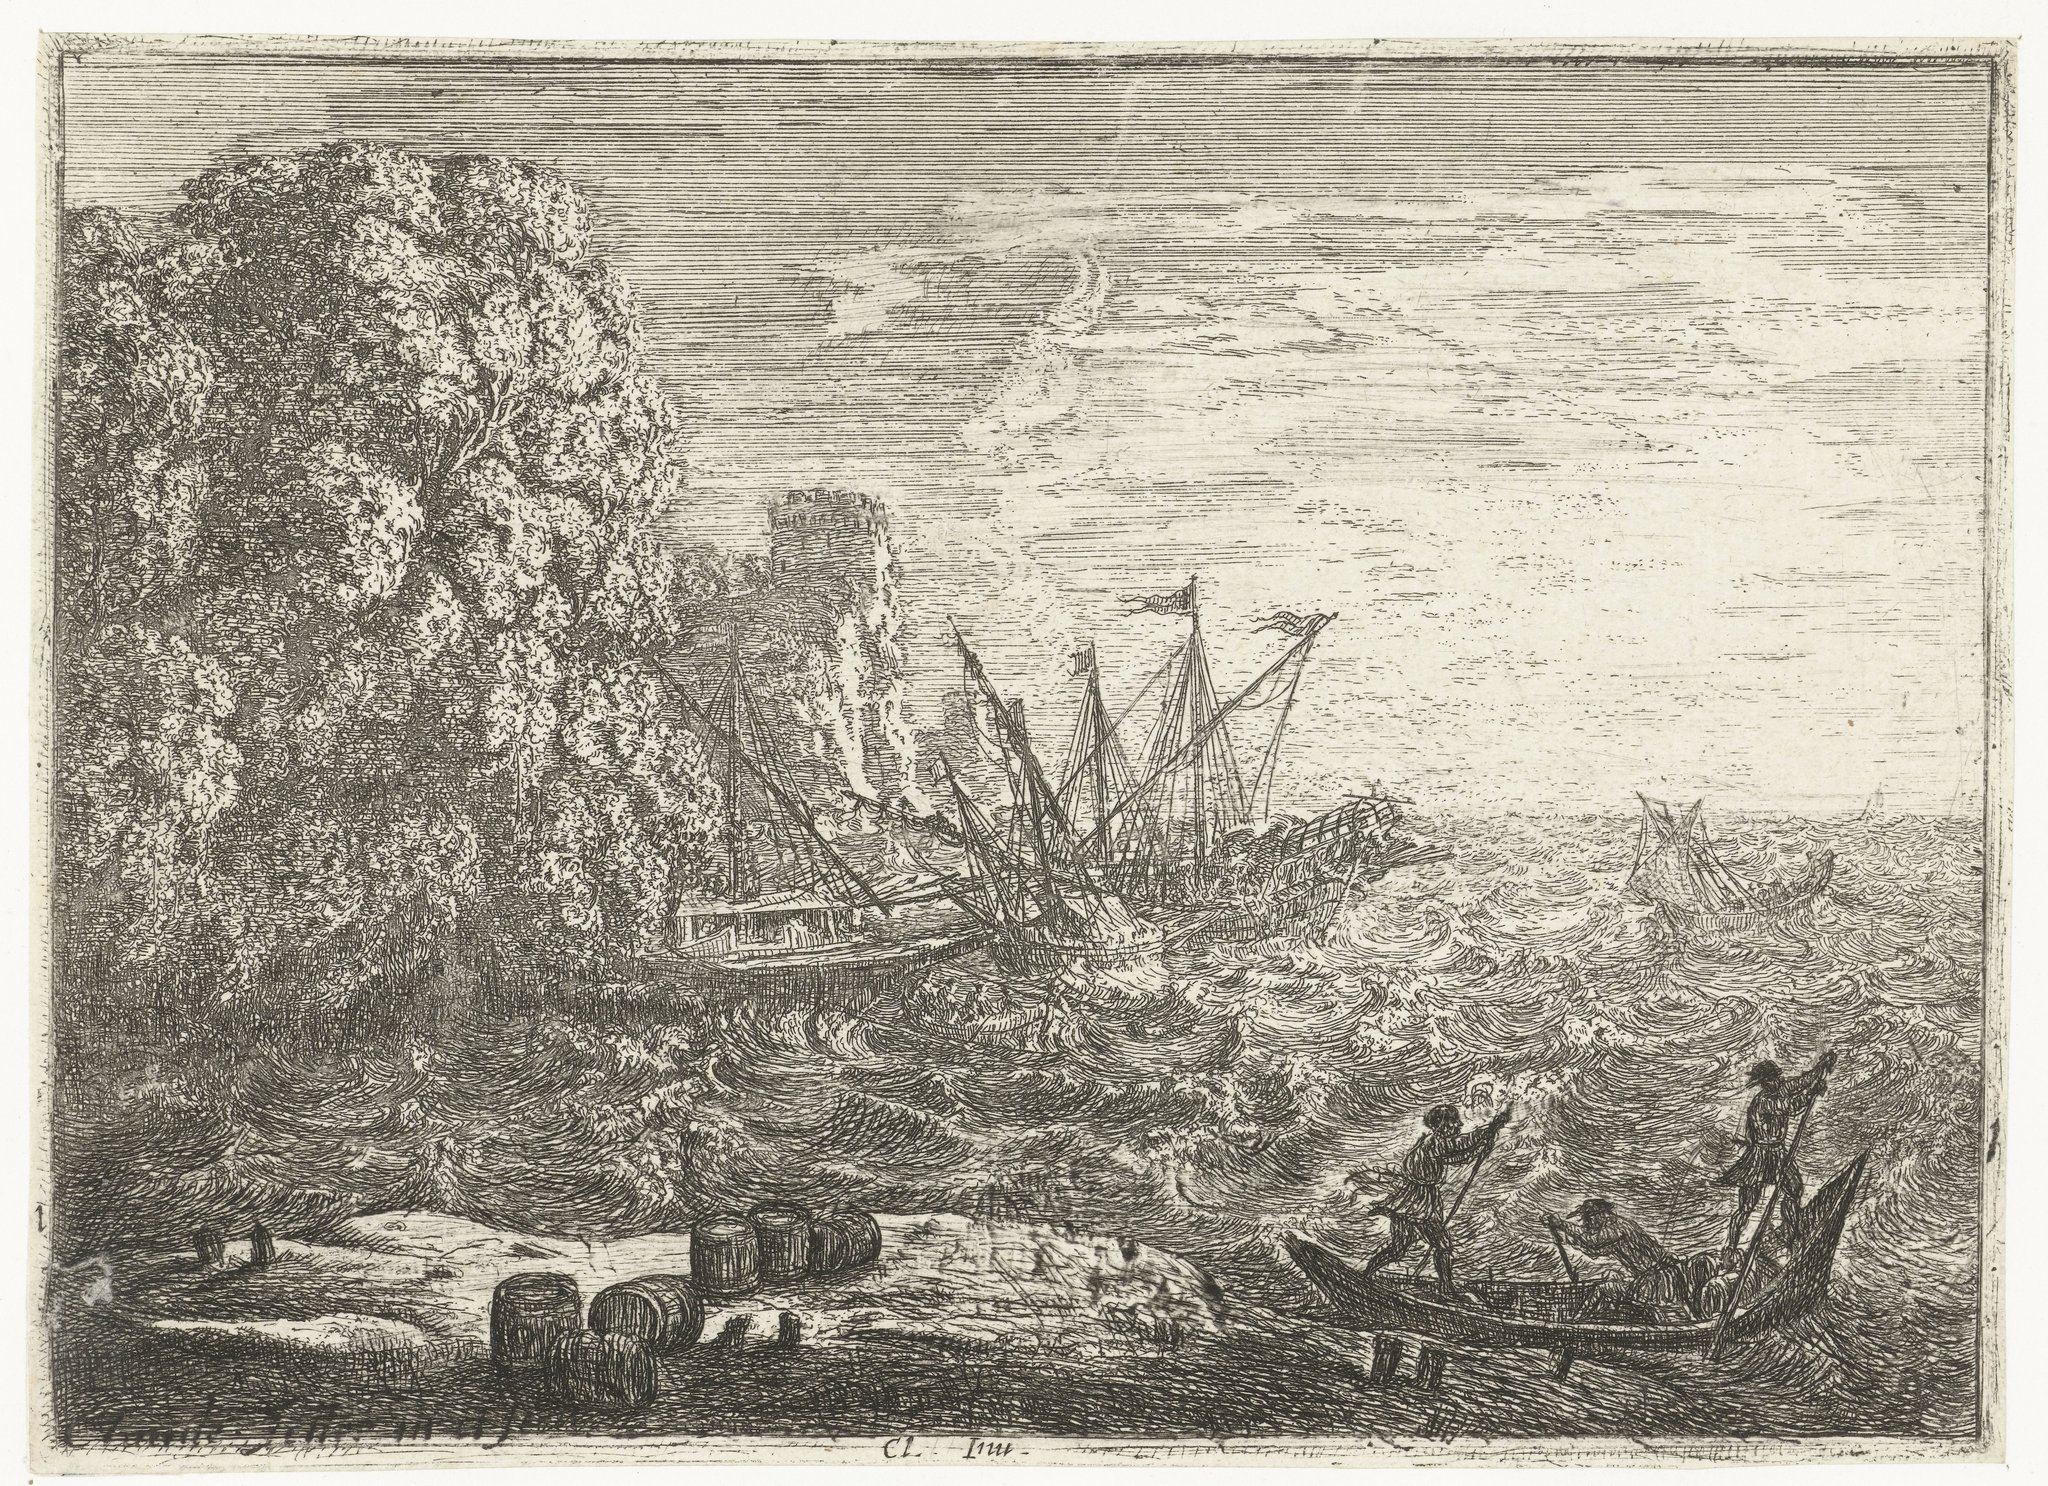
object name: print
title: La Tempête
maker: claude lorrain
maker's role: draughtsman, print maker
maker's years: 1604-1682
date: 1630-1631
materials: paper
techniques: etching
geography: rome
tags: storm at sea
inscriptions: collector's mark: Lugt 240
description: Storm op zee, met een aantal schepen vlak bij de kust. Op de voorgrond drie mannen in een sloep.